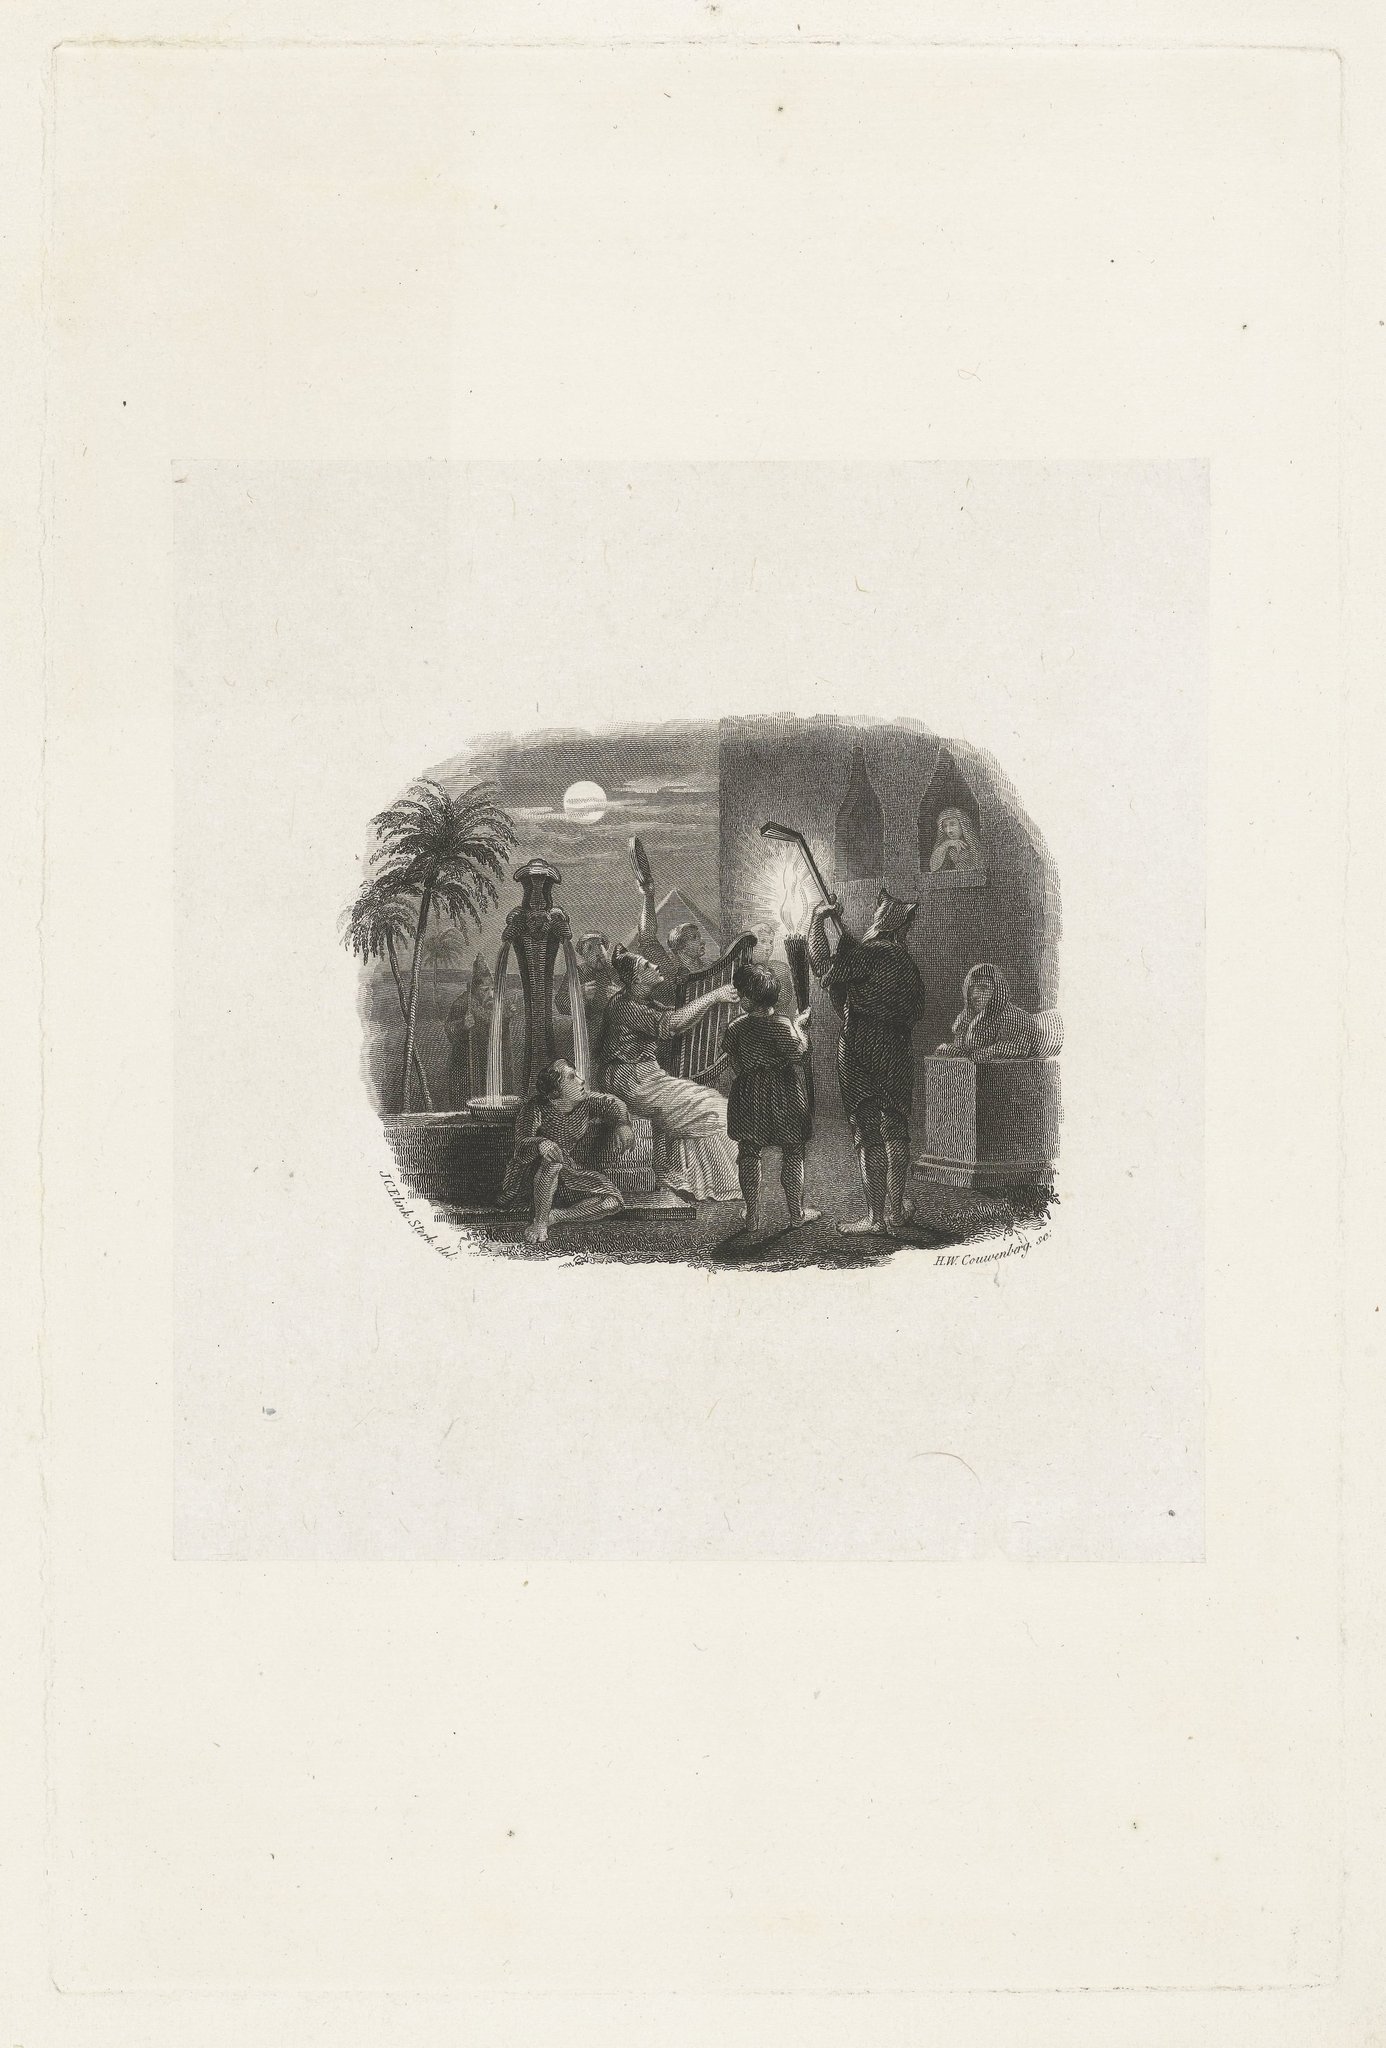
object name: book illustration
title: Groepje muzikanten speelt 's nachts voor het raam van een vrouw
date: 1830-1845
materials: paper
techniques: engraving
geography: amsterdam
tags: small group of musicians, chamber orchestra, jazz band, human figure at (open) window, seen from outside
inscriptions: collector's mark: Lugt 2228